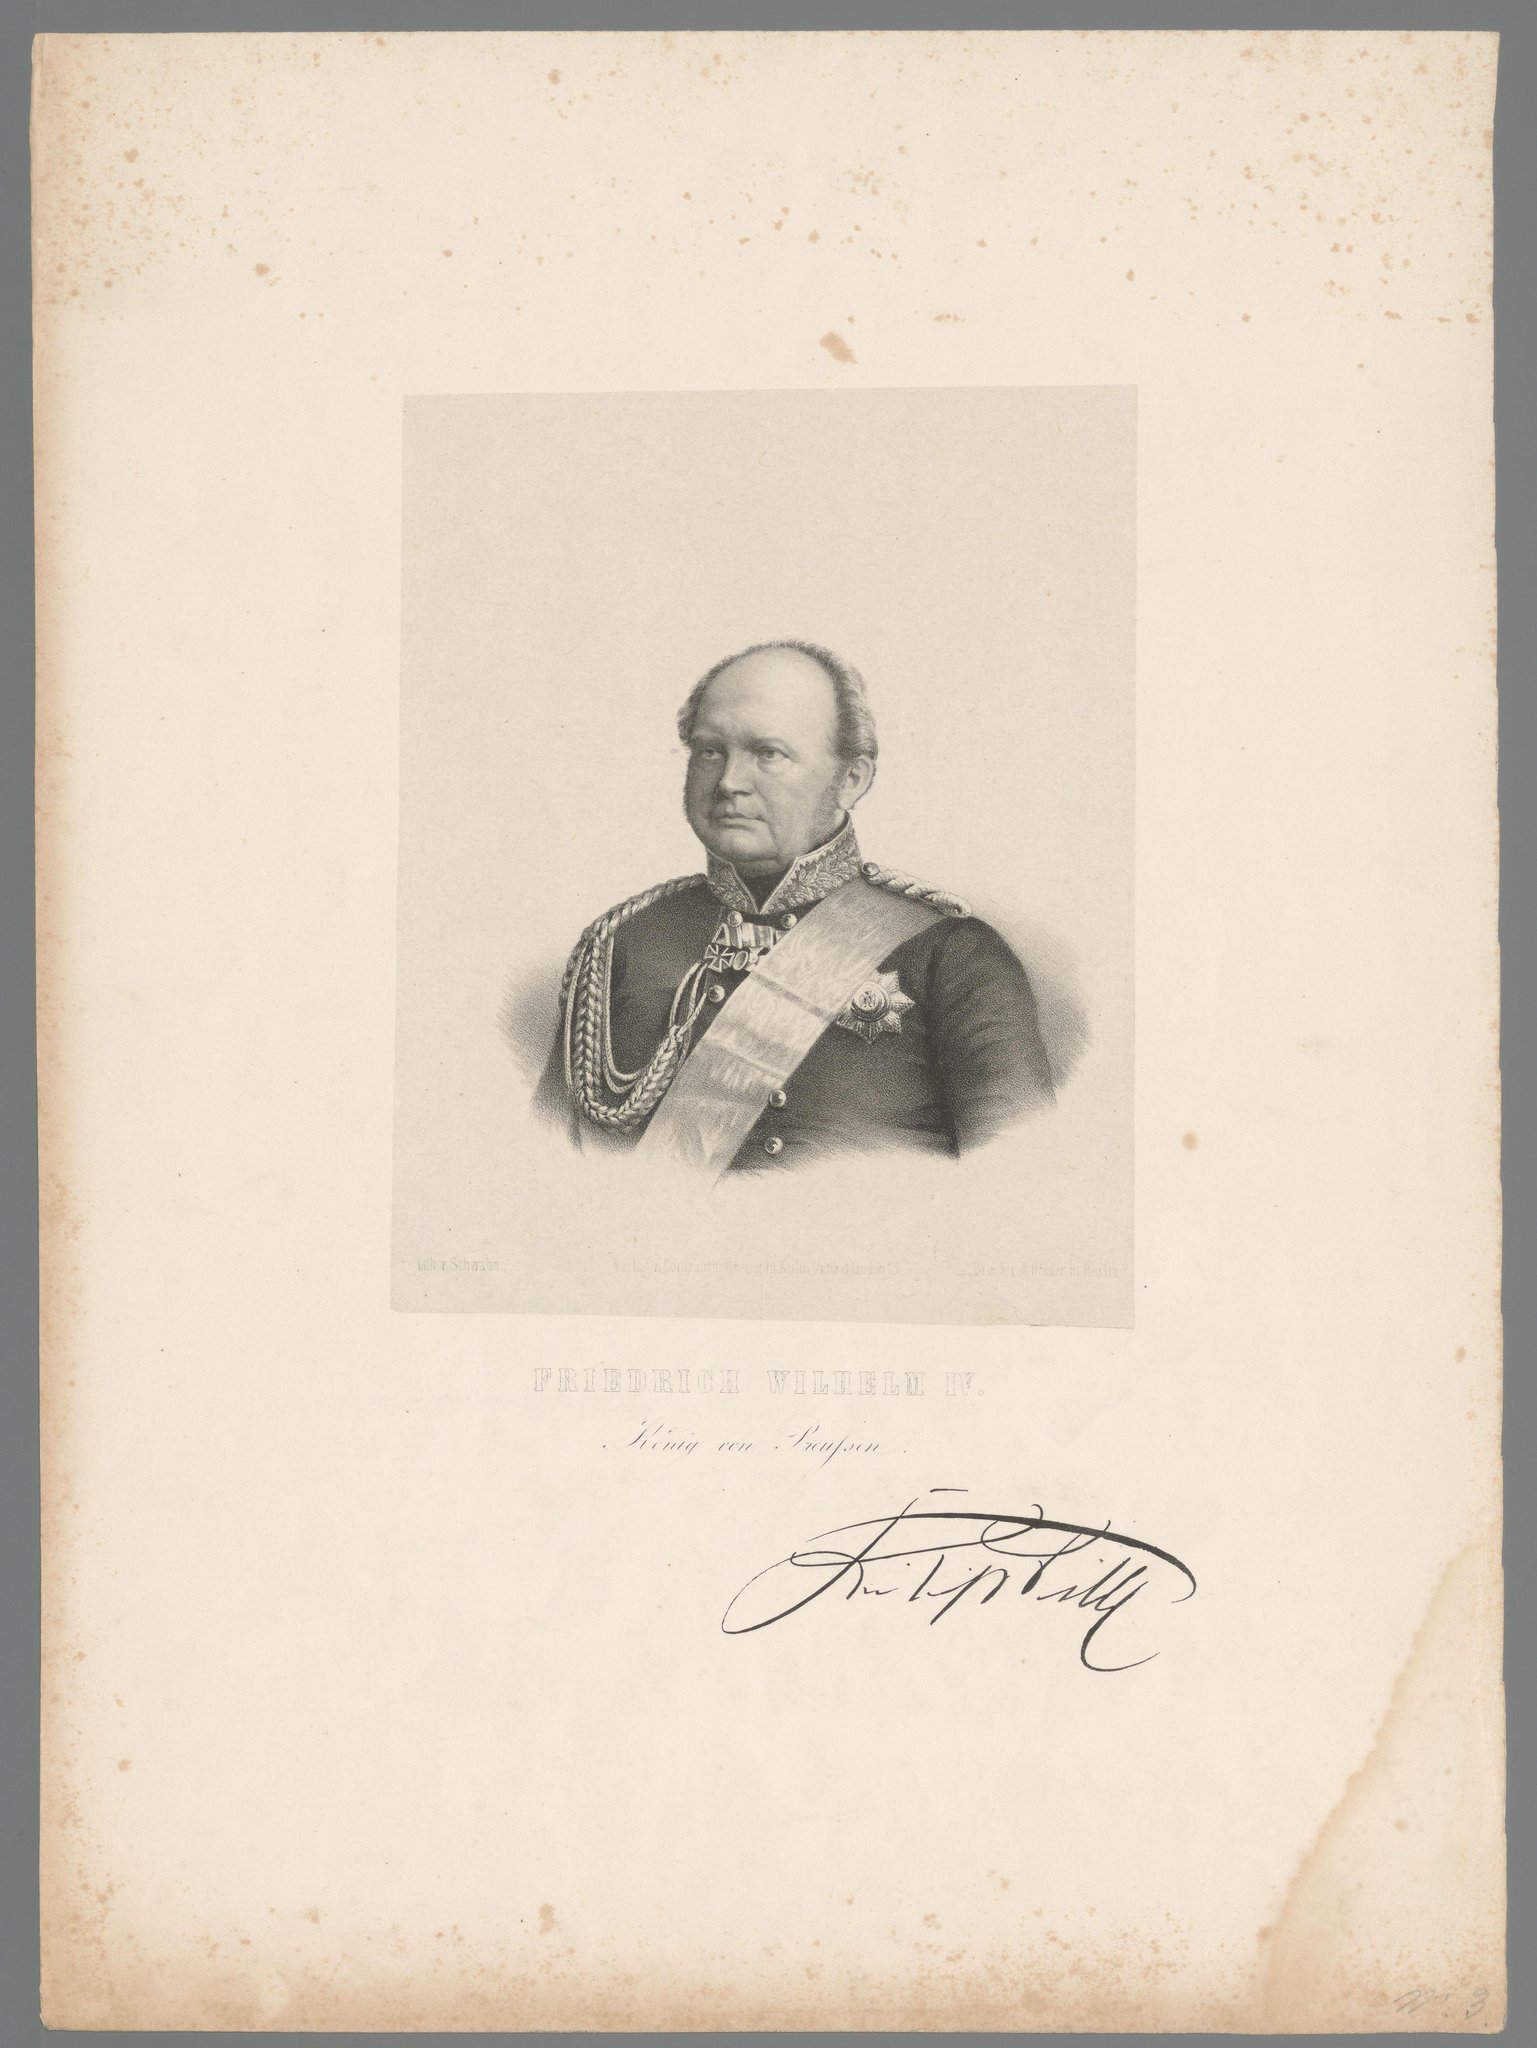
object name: print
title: Friedrich Wilhelm IV, König von Preussen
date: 1830-1860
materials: paper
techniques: lithograph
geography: berlin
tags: frederik willem iv (koning van pruisen), adult man, historical persons, (military) uniforms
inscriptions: collector's mark: Lugt 2228